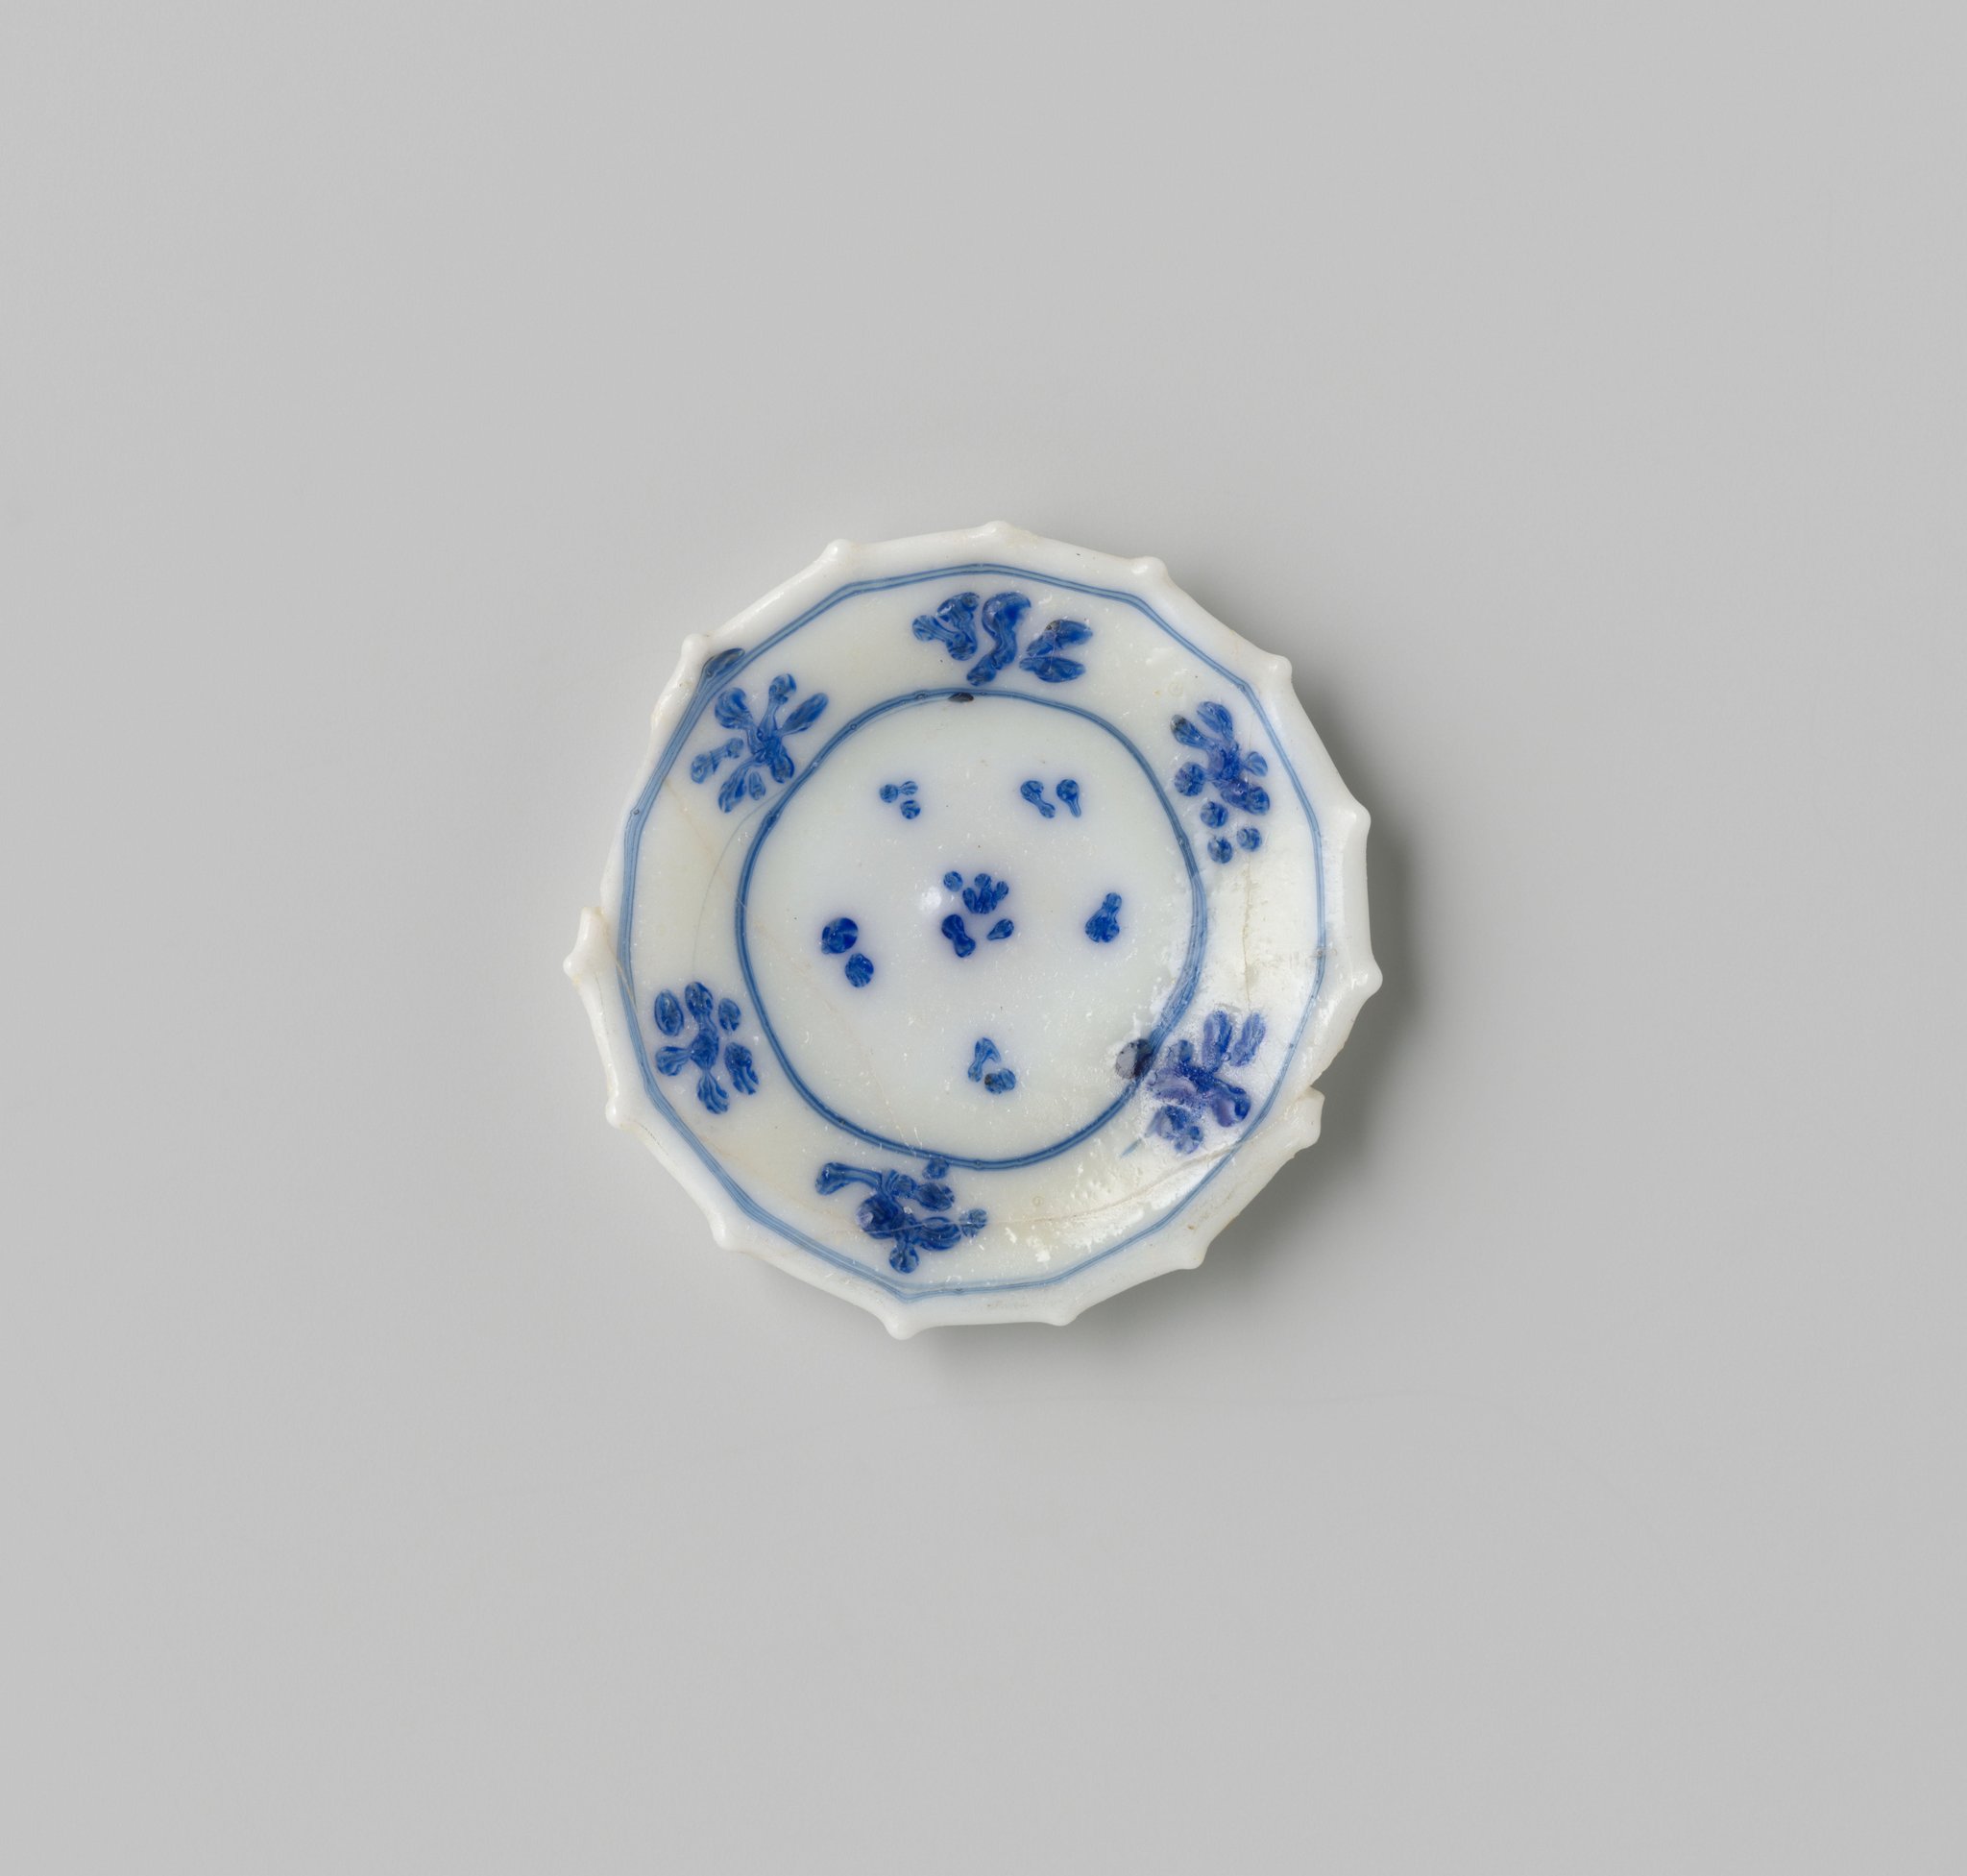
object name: miniature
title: Schotel van melkglas met blauwe emailverf beschildering, imitatie Chinees porselein; stippen in het plat, rand met zes bloemen; dubbelwandig met in punten geknepen rand.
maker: Anonymous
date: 1675-1710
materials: glass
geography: amsterdam